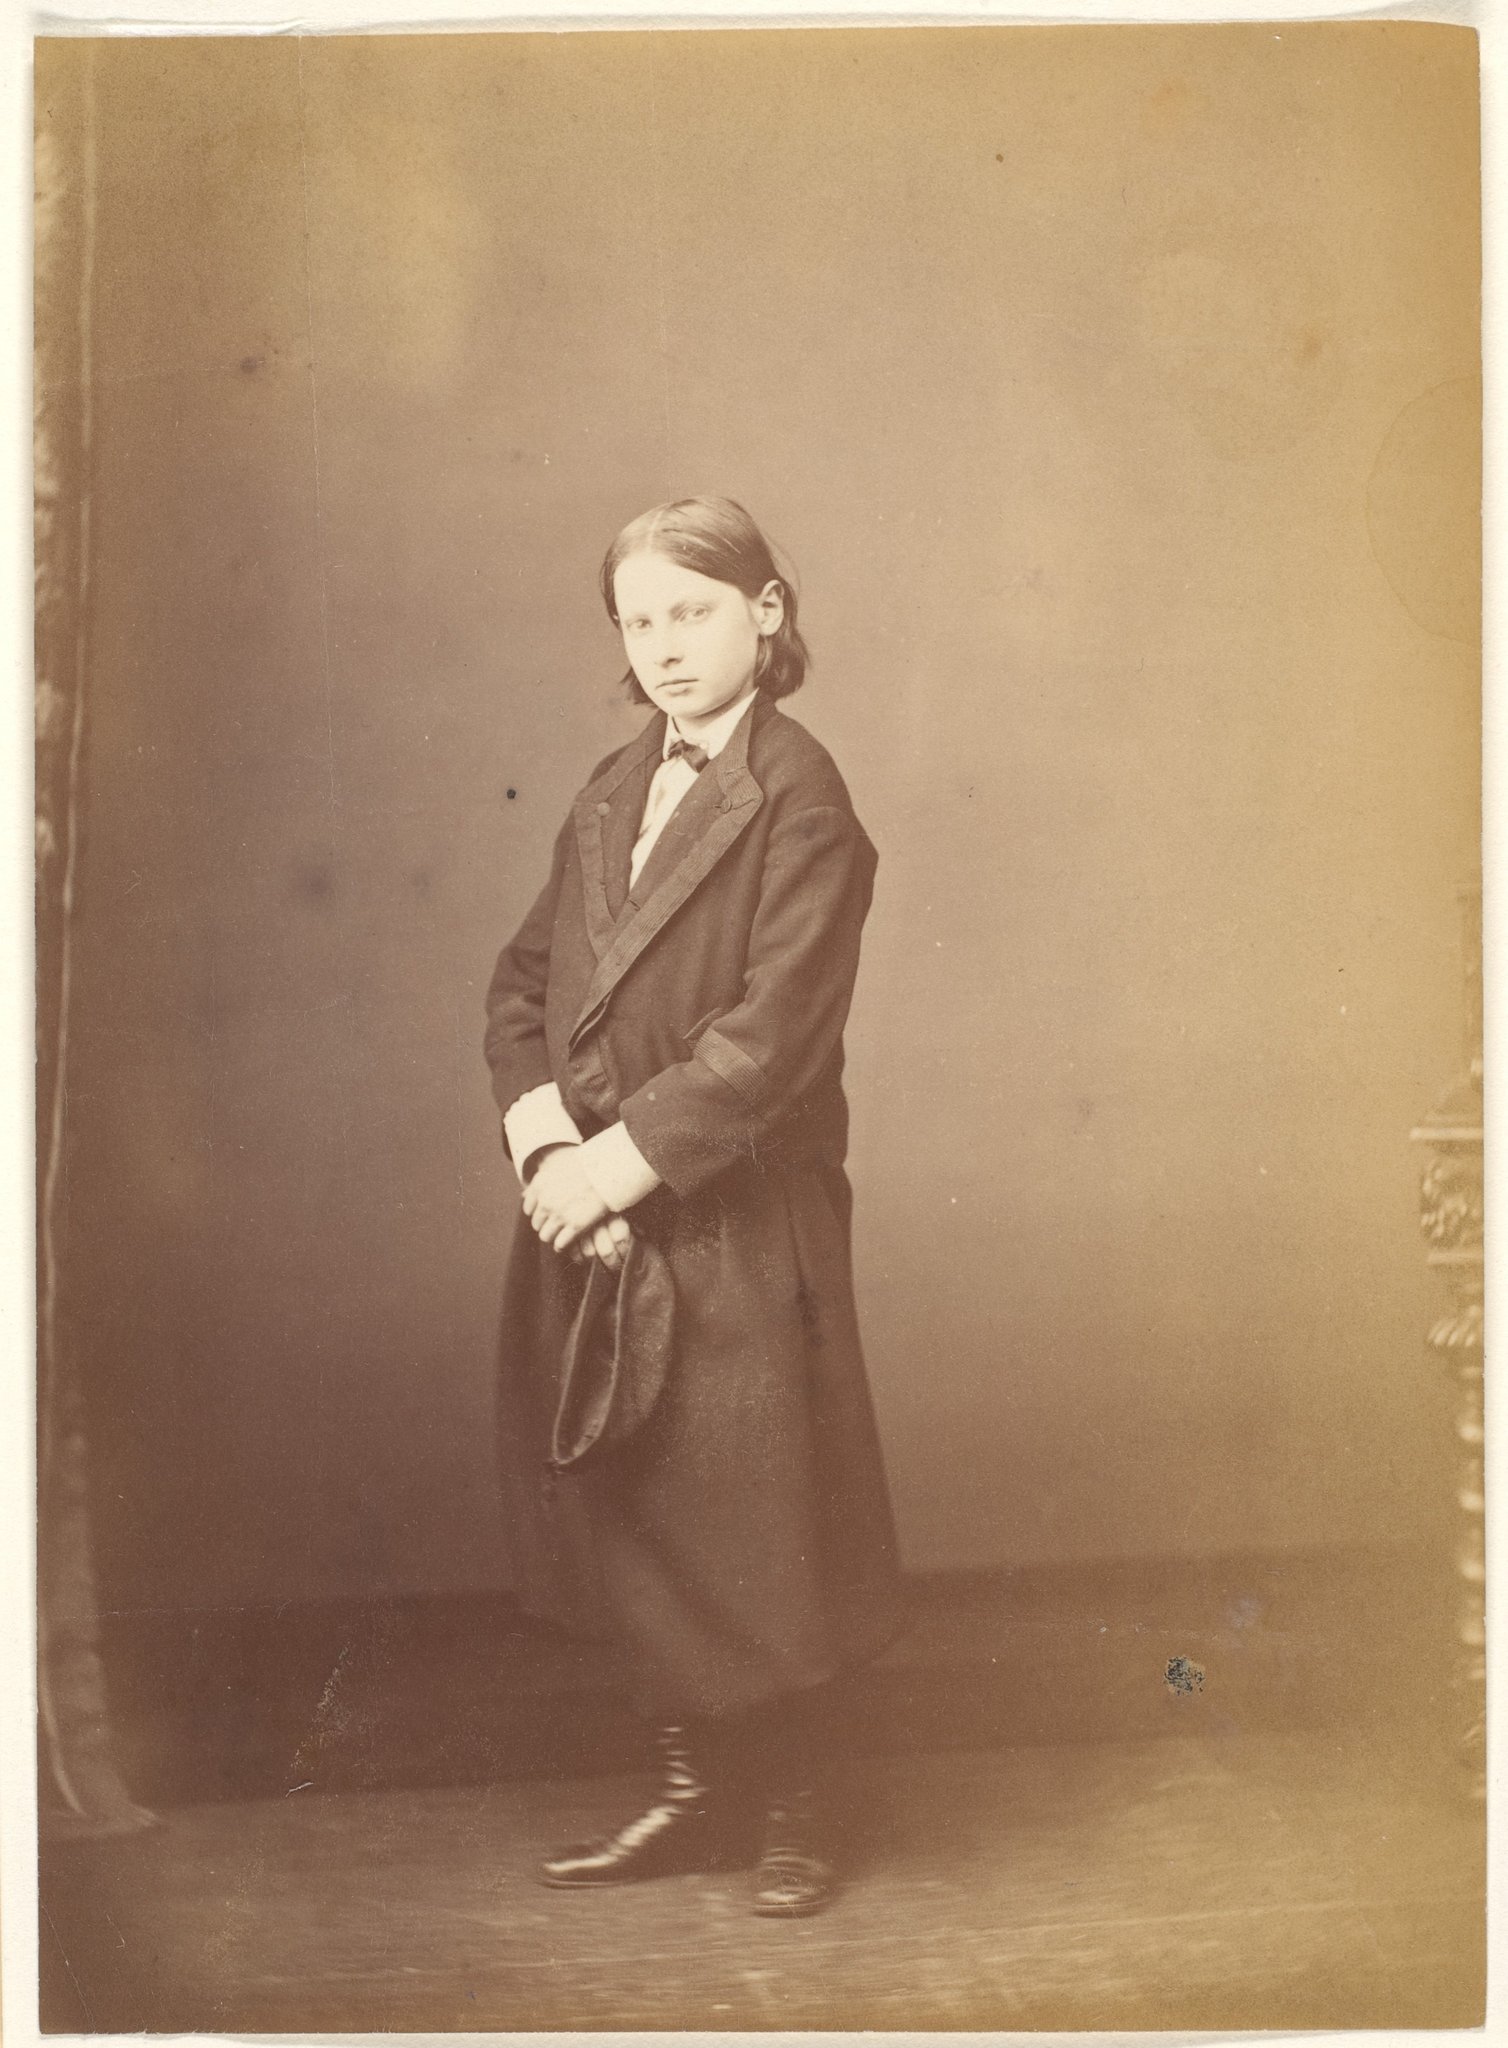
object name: photograph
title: Le Grand Russe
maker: pierre-louis pierson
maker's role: artist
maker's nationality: french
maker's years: 1822-1913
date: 1860-1869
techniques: albumen silver print, glass negative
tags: children,portraits